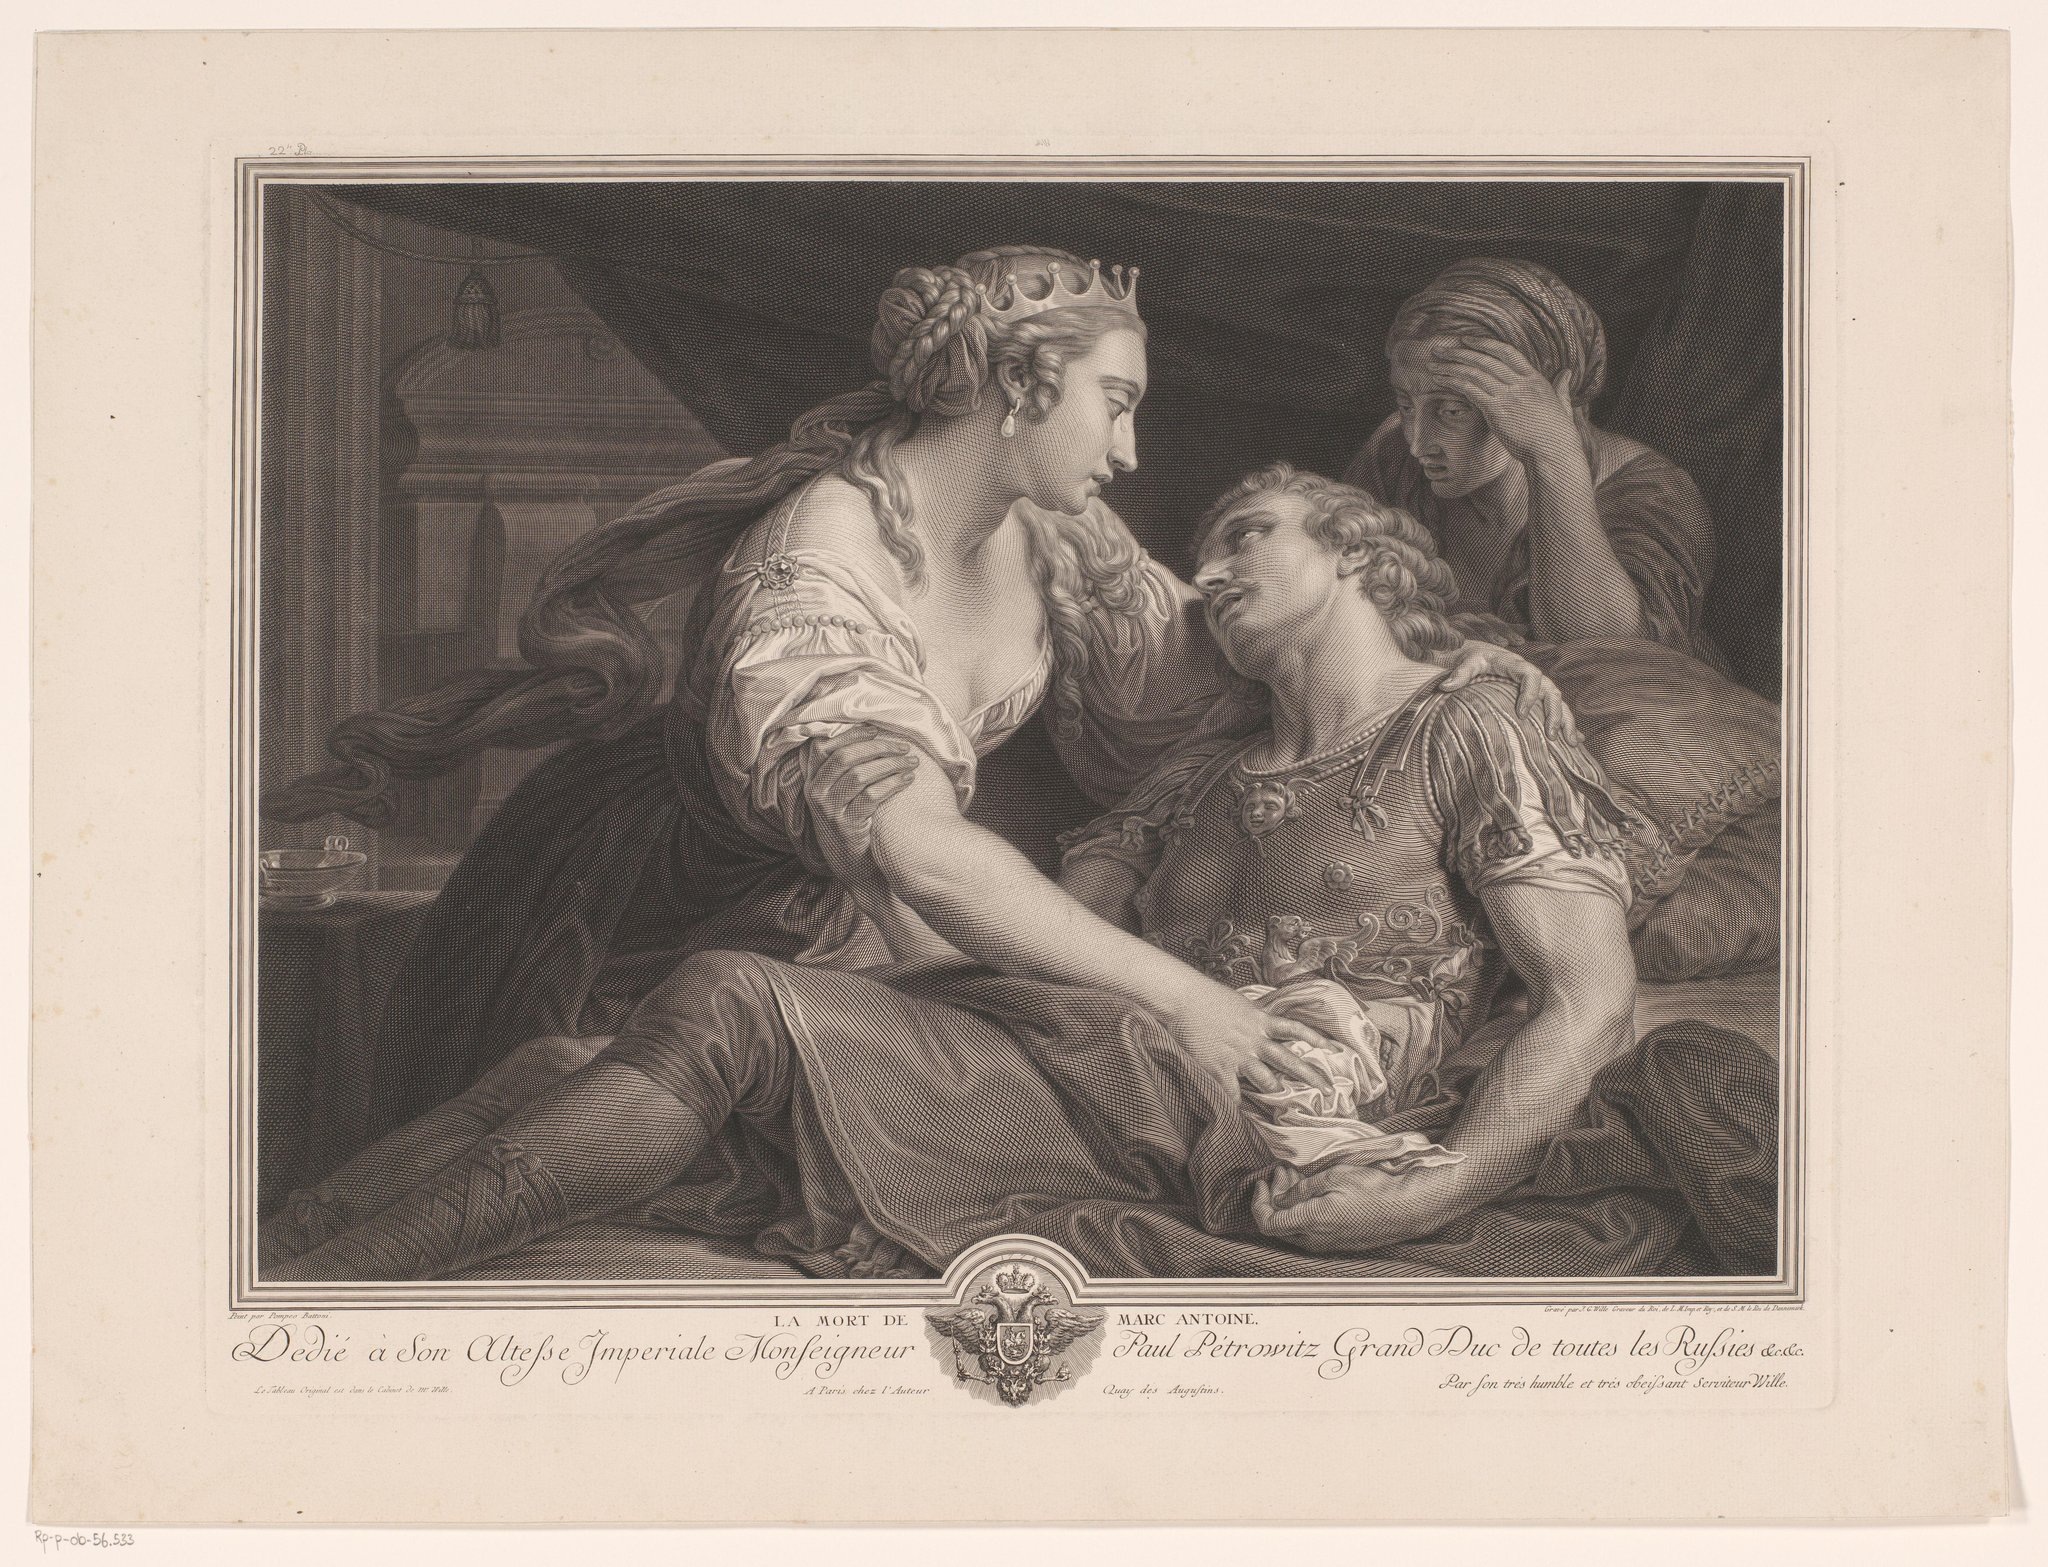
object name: print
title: Marcus Antonius sterft in de armen van Cleopatra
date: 1778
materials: paper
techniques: engraving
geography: paris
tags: death of mark antony: he dies after having stabbed himself: cleopatra grieves at his bedside, armorial bearing, heraldry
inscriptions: collector's mark: Lugt 240